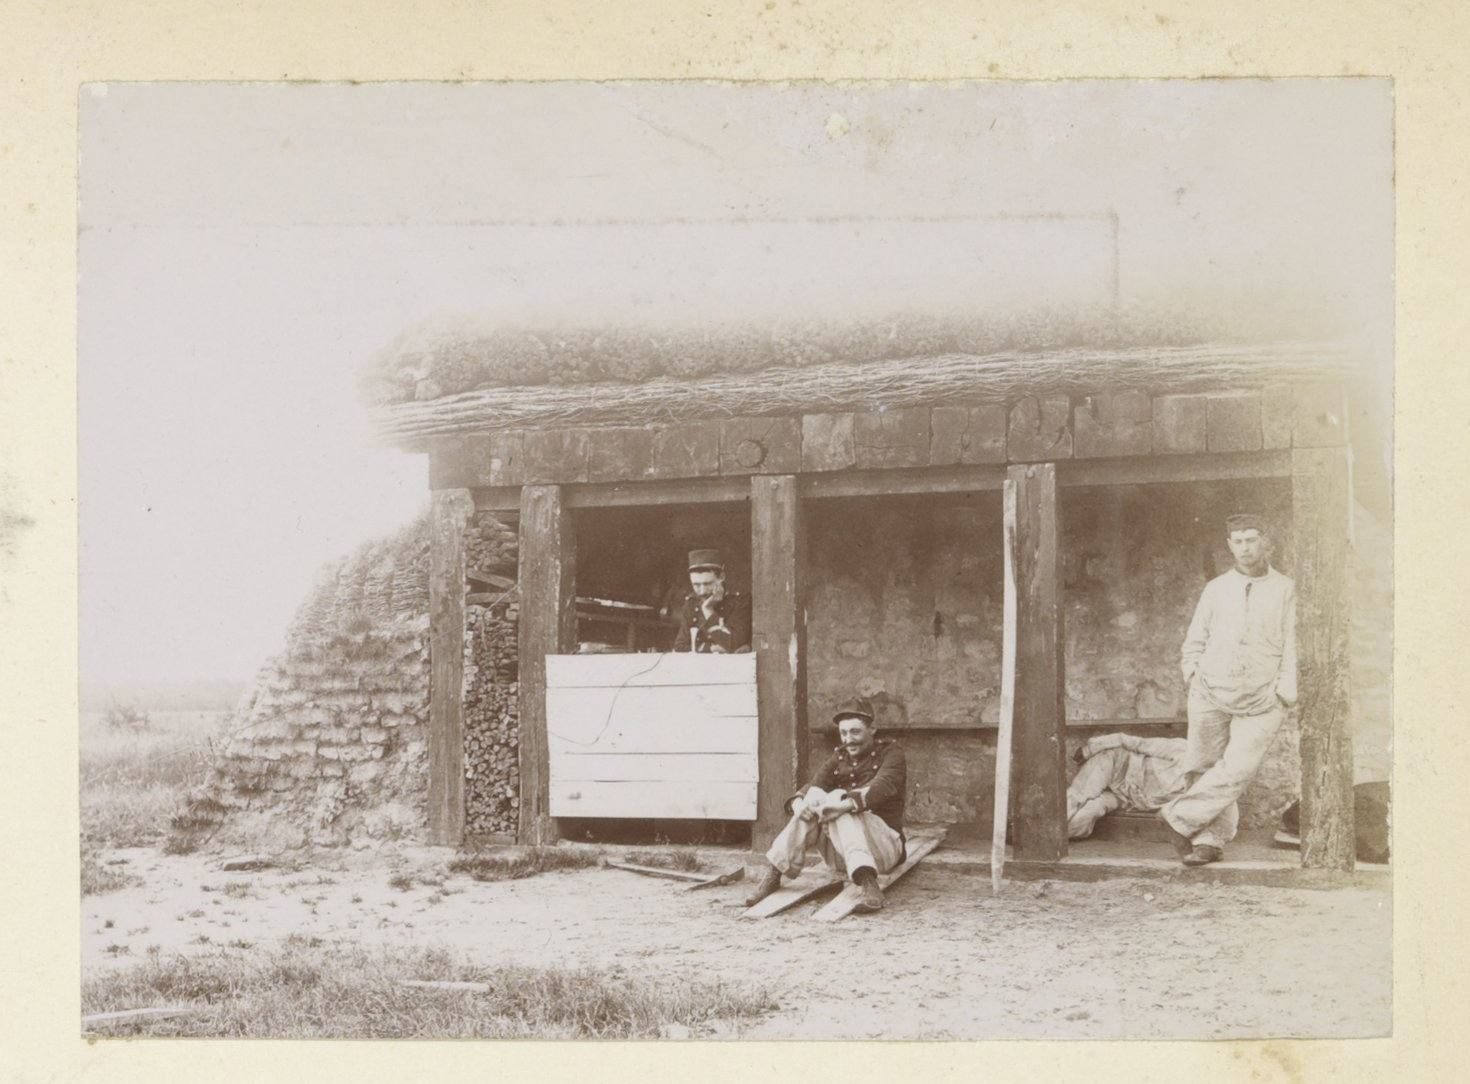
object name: photograph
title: Militairen op een schietbaan, vermoedelijk in Frankrijk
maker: Anonymous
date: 1900-1910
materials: paper, photographic support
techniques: daylight paper print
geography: france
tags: artillery range, firing range, shooting range ~ military training, land forces, france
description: Onderdeel van Fotoalbum van een Franse amateurfotograaf met opnames van een familie, distilleerderij Delizy & Doistau Fils, het leger en bezienswaardigheden in Frankrijk.